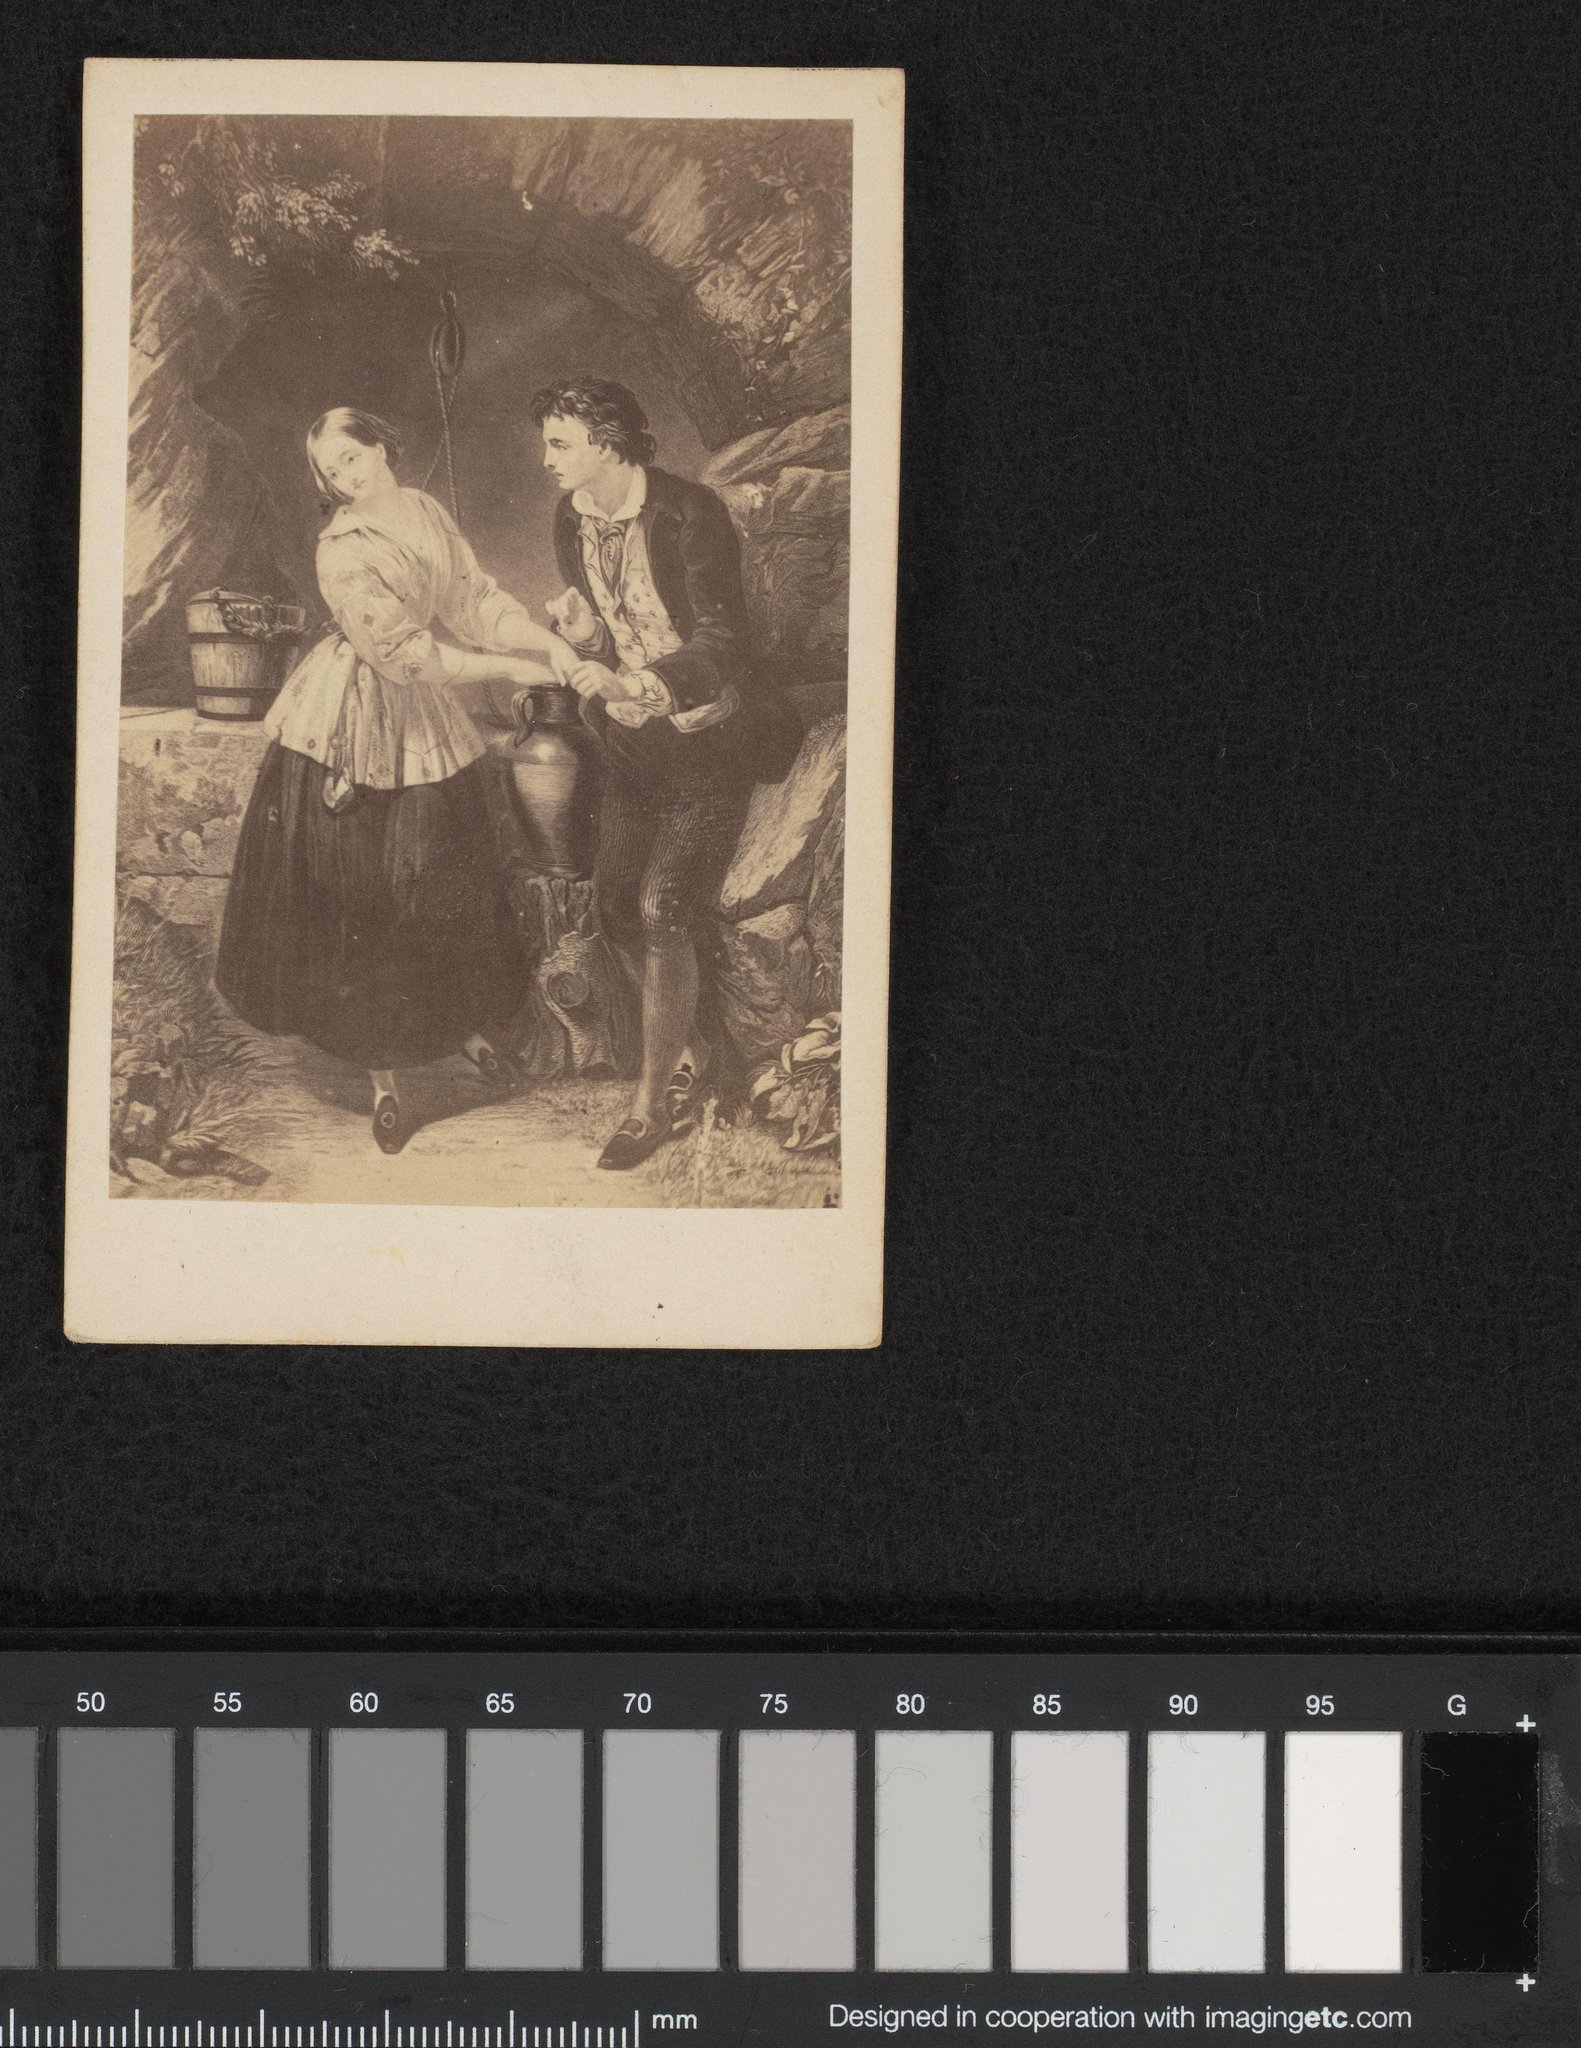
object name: reproduction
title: Fotoreproductie van een schilderij, man en vrouw bij een put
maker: Anonymous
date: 1860-1900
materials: cardboard, photographic support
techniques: albumen print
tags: well, lovers' tussle